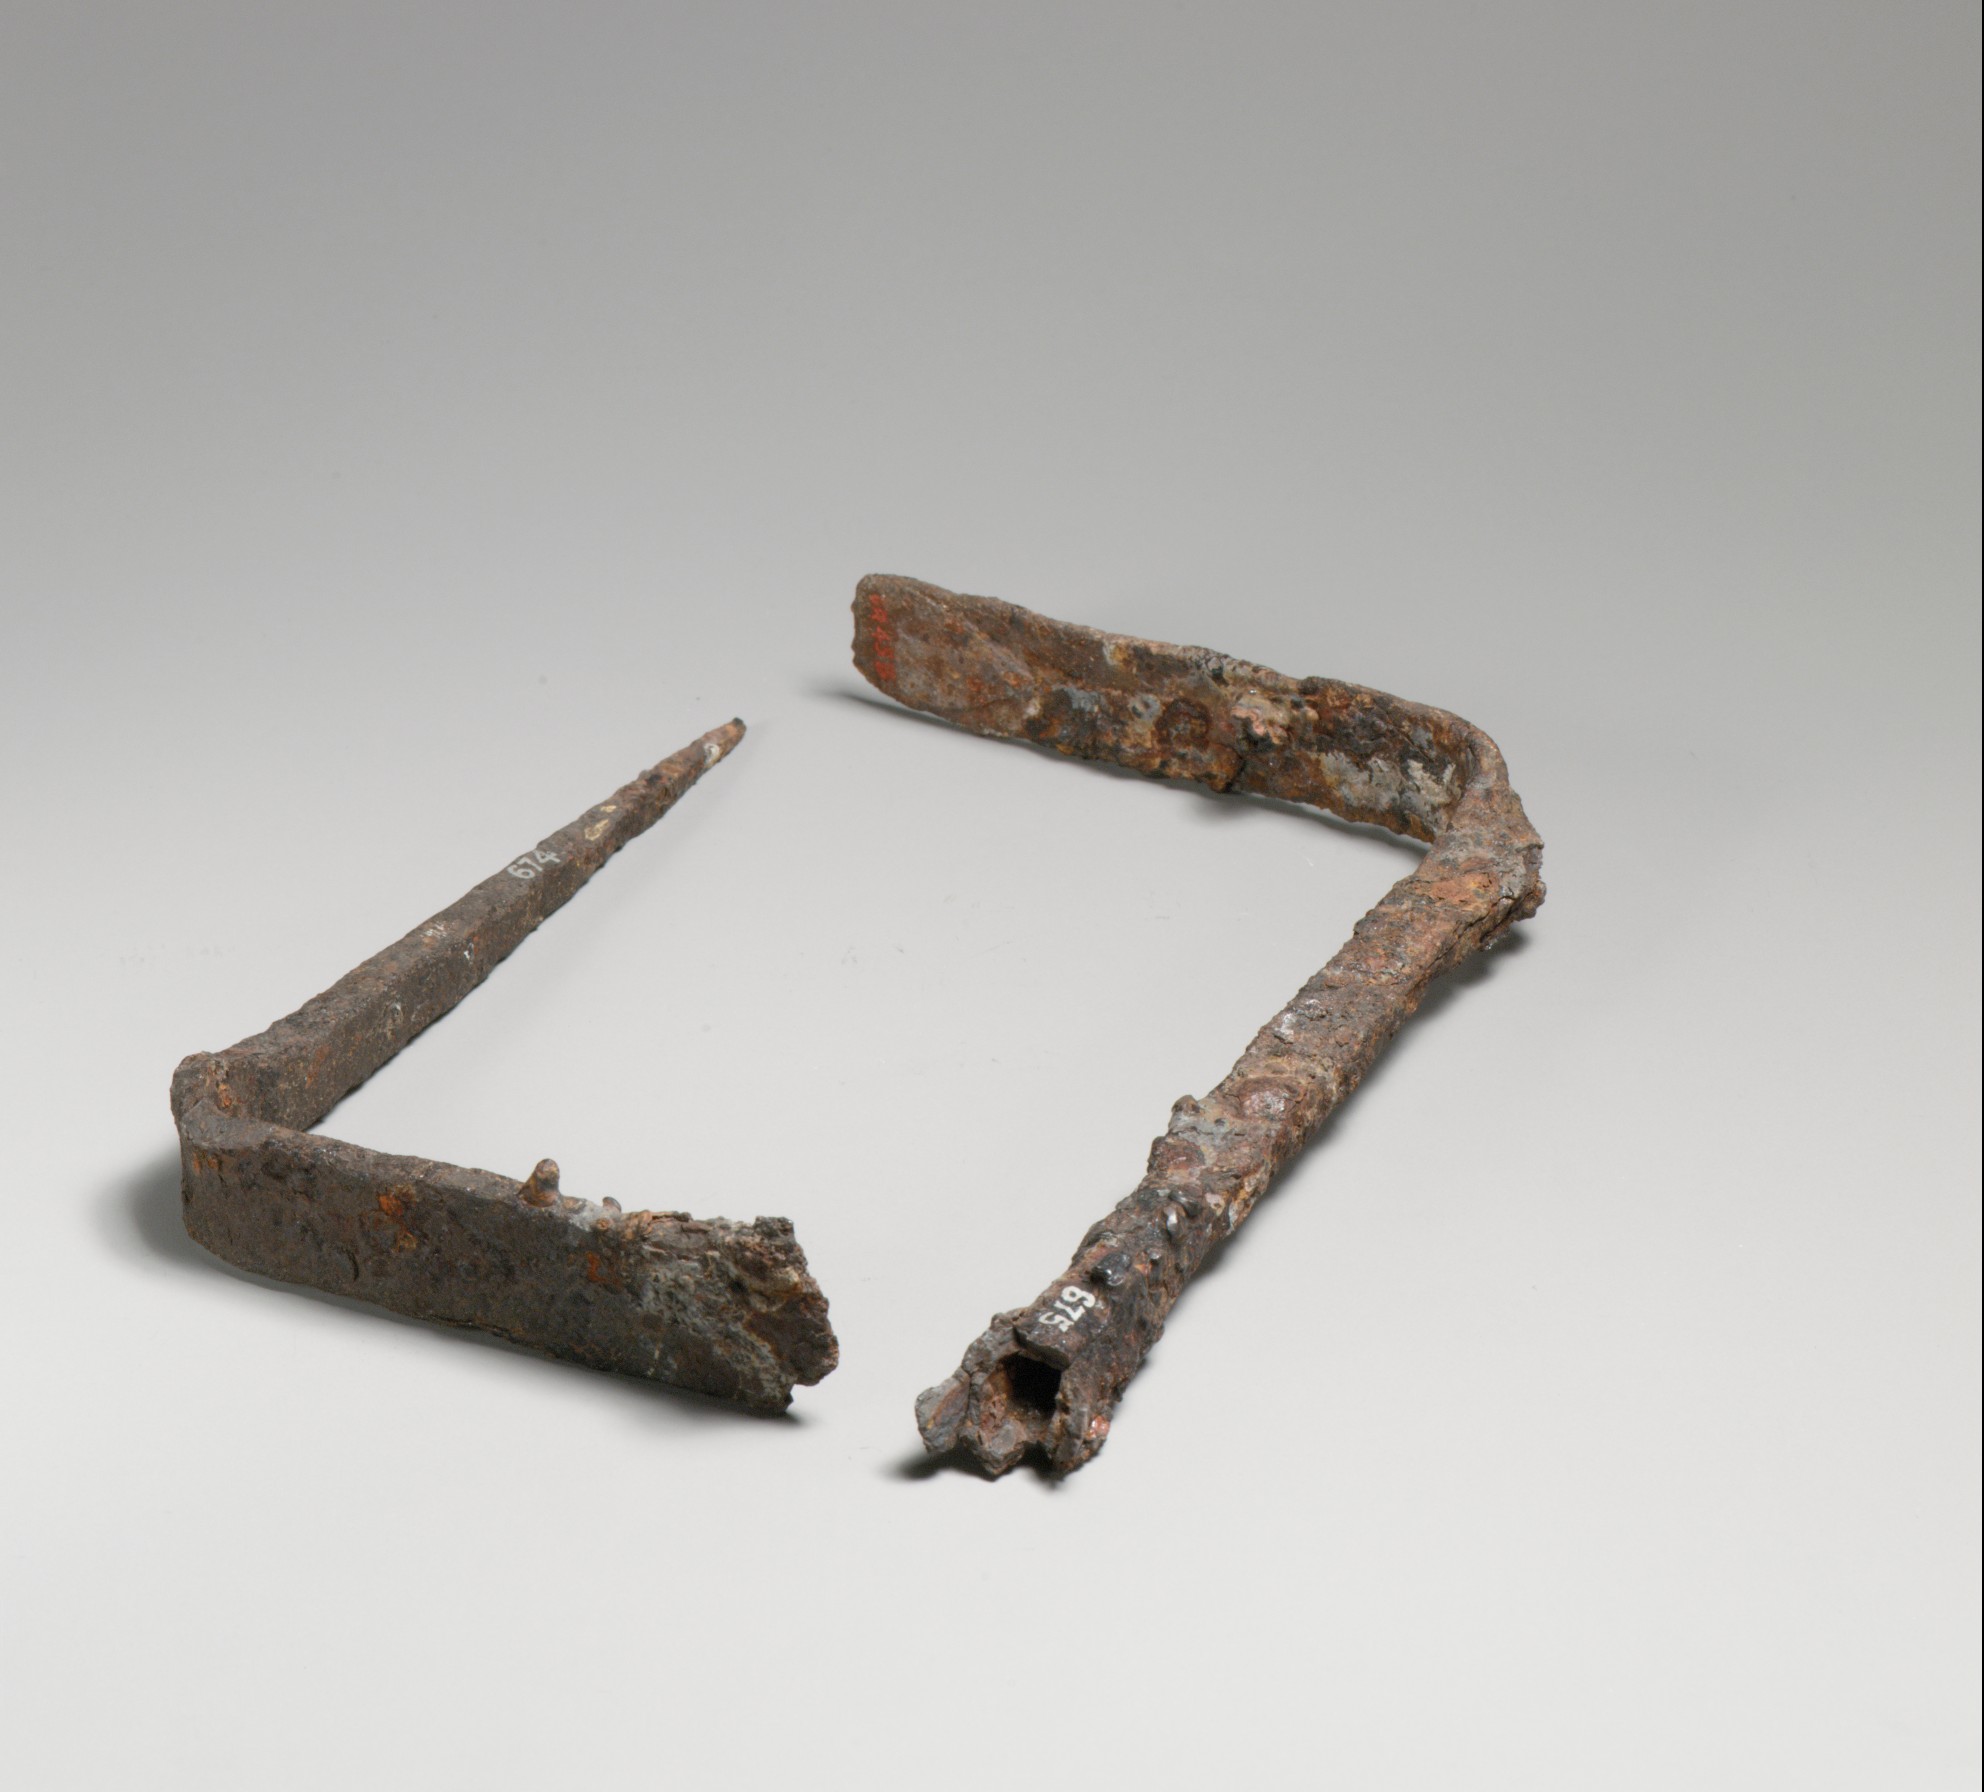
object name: fire rake fragment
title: Two fragmentary iron fire-rakes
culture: etruscan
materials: iron